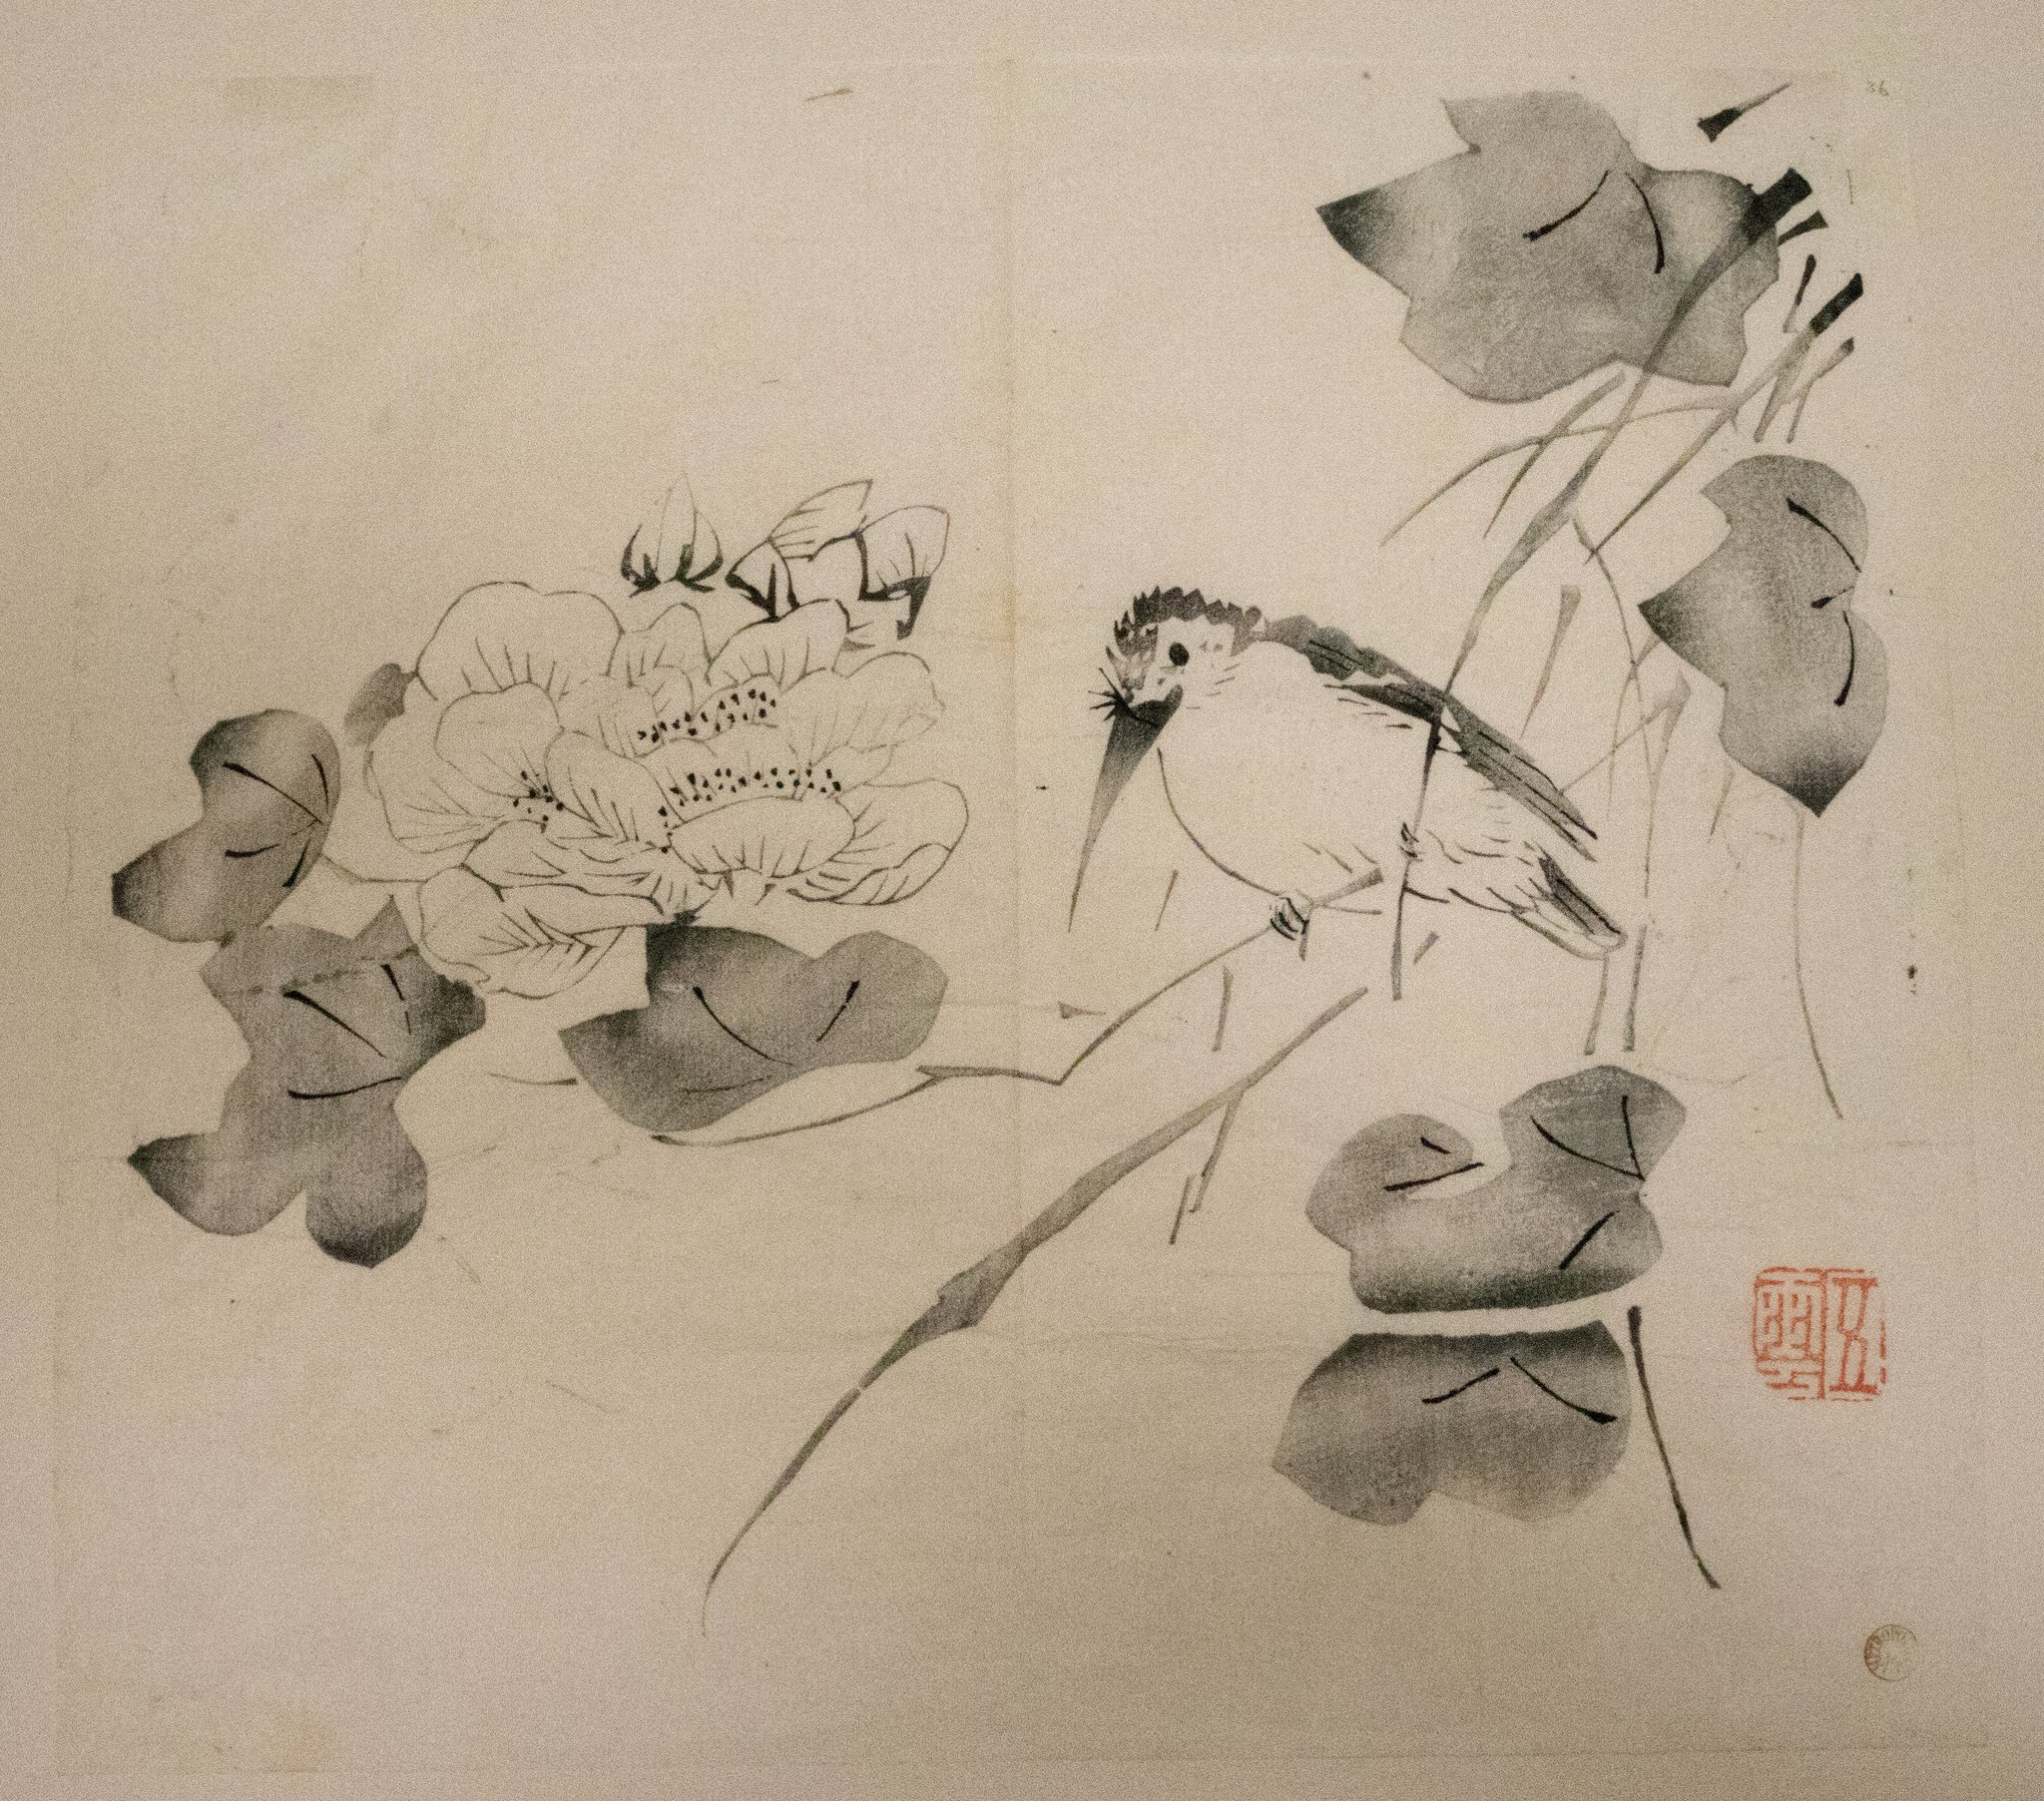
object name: print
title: Page from Shi Zhu Zhai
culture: chinese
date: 1736-1795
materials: ink, paper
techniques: polychrome, woodblock print